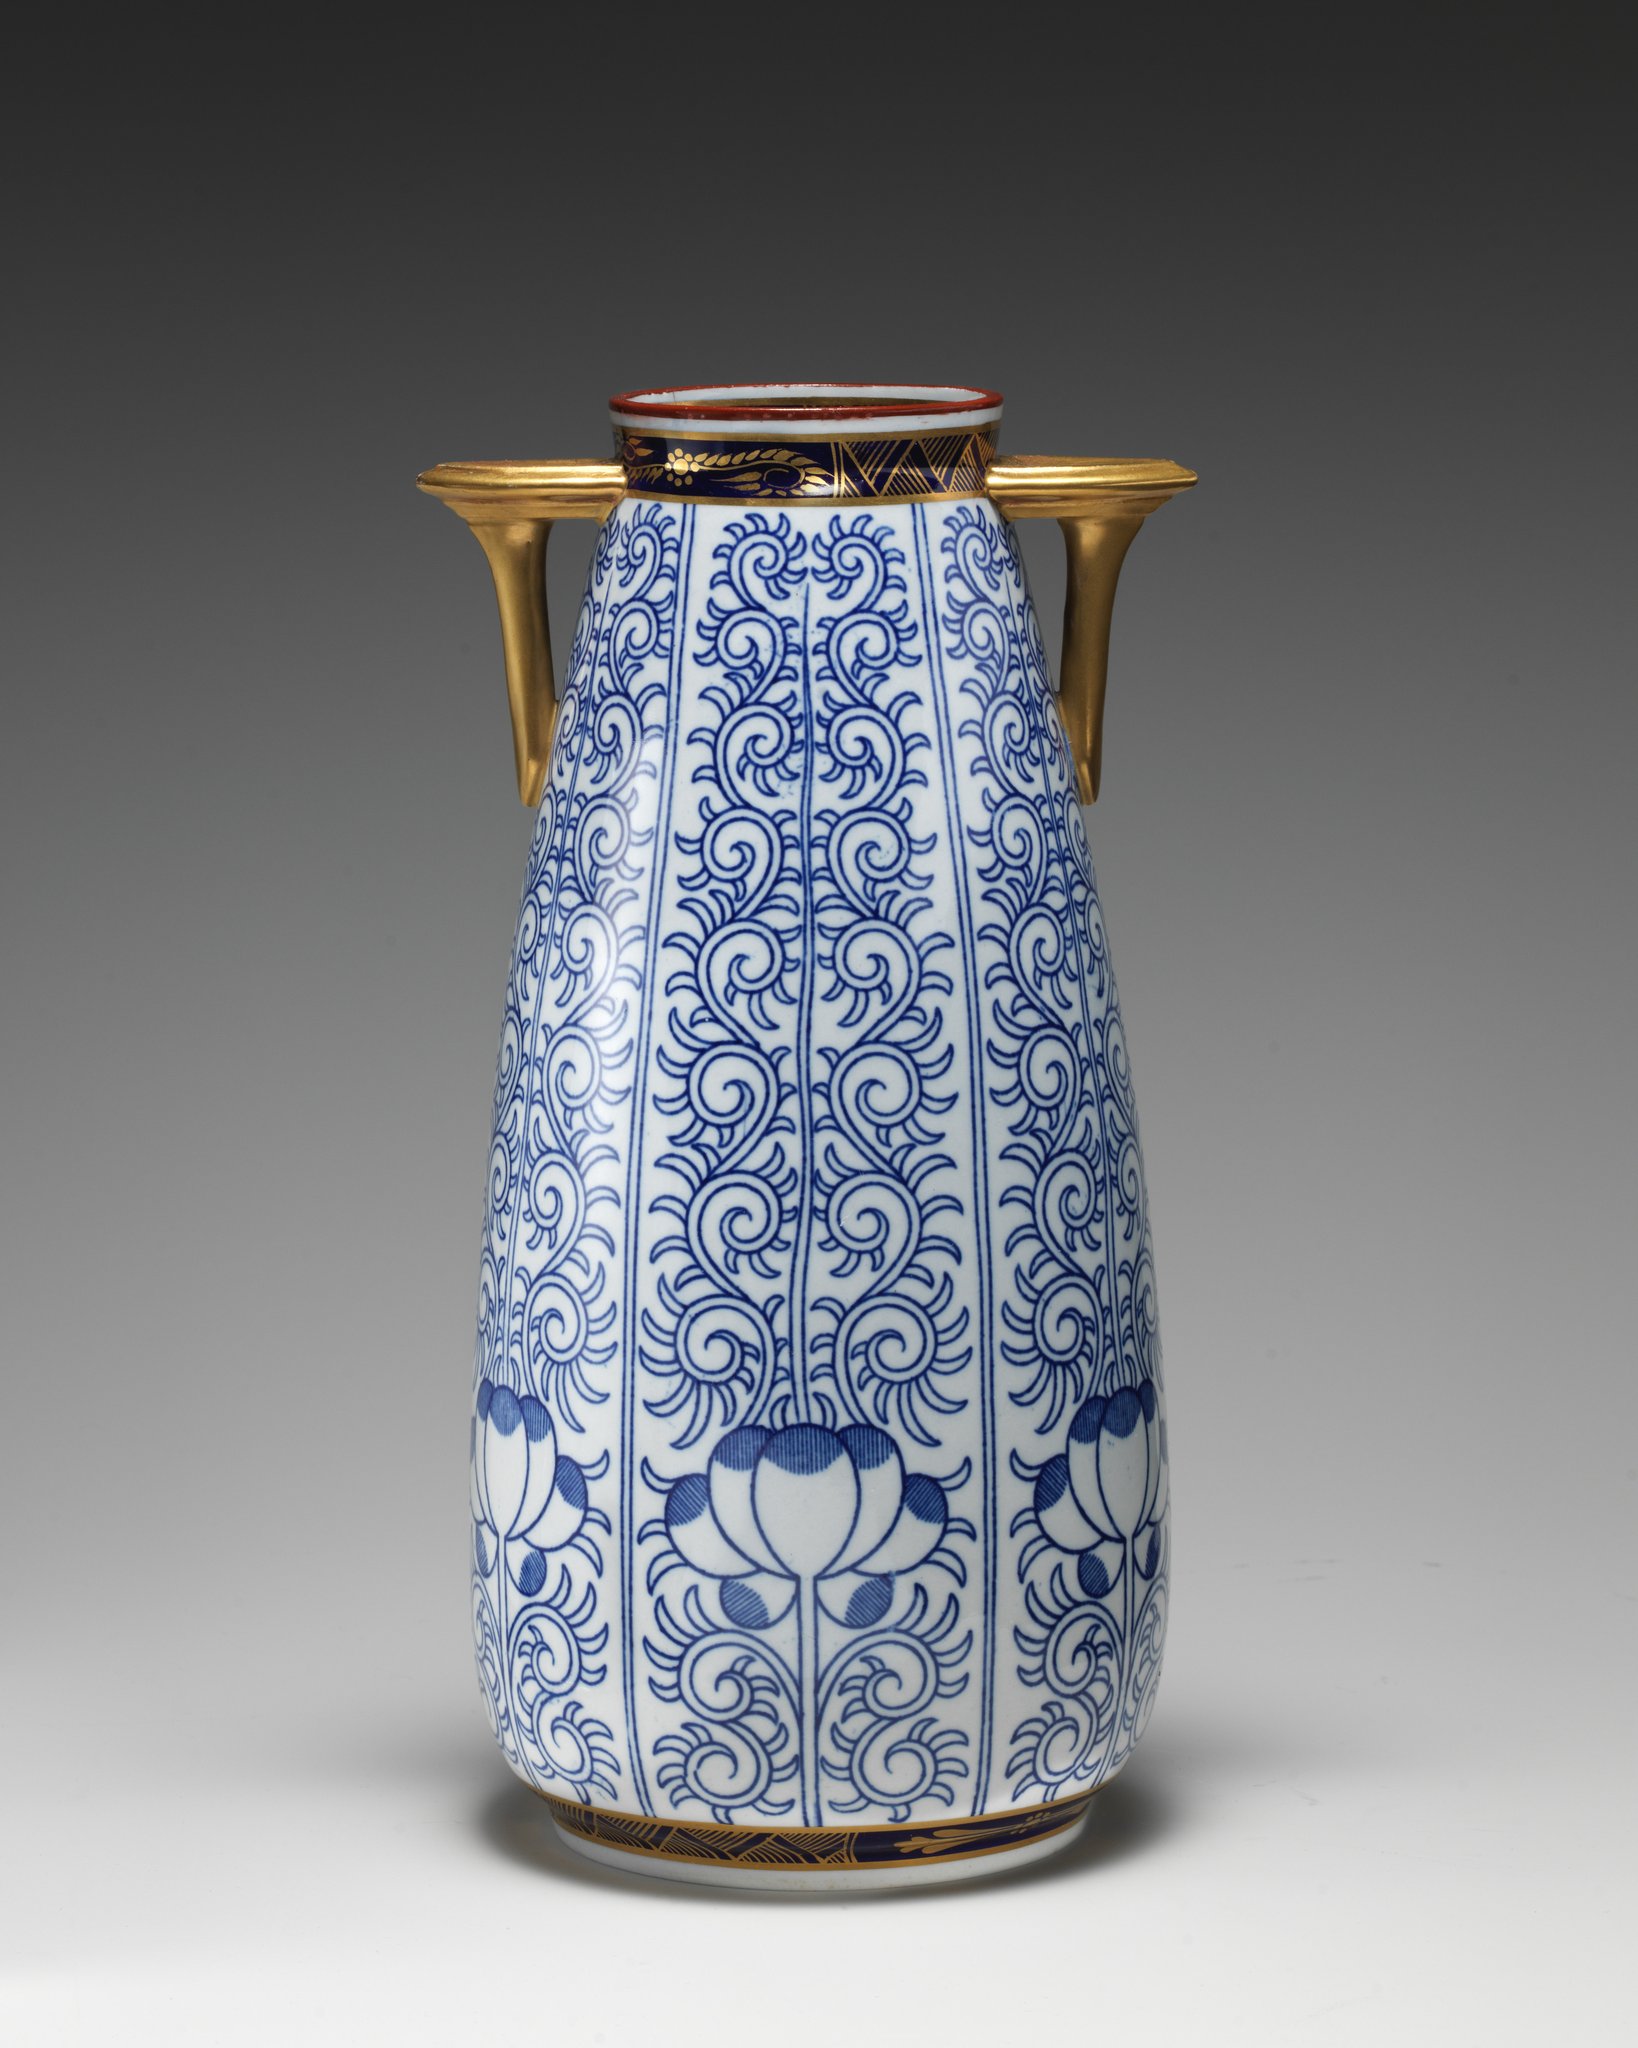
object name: vase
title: Vase with "lily pattern" (one of a pair)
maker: worcester factory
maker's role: maker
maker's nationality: british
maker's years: 1751-2008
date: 1879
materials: bone china